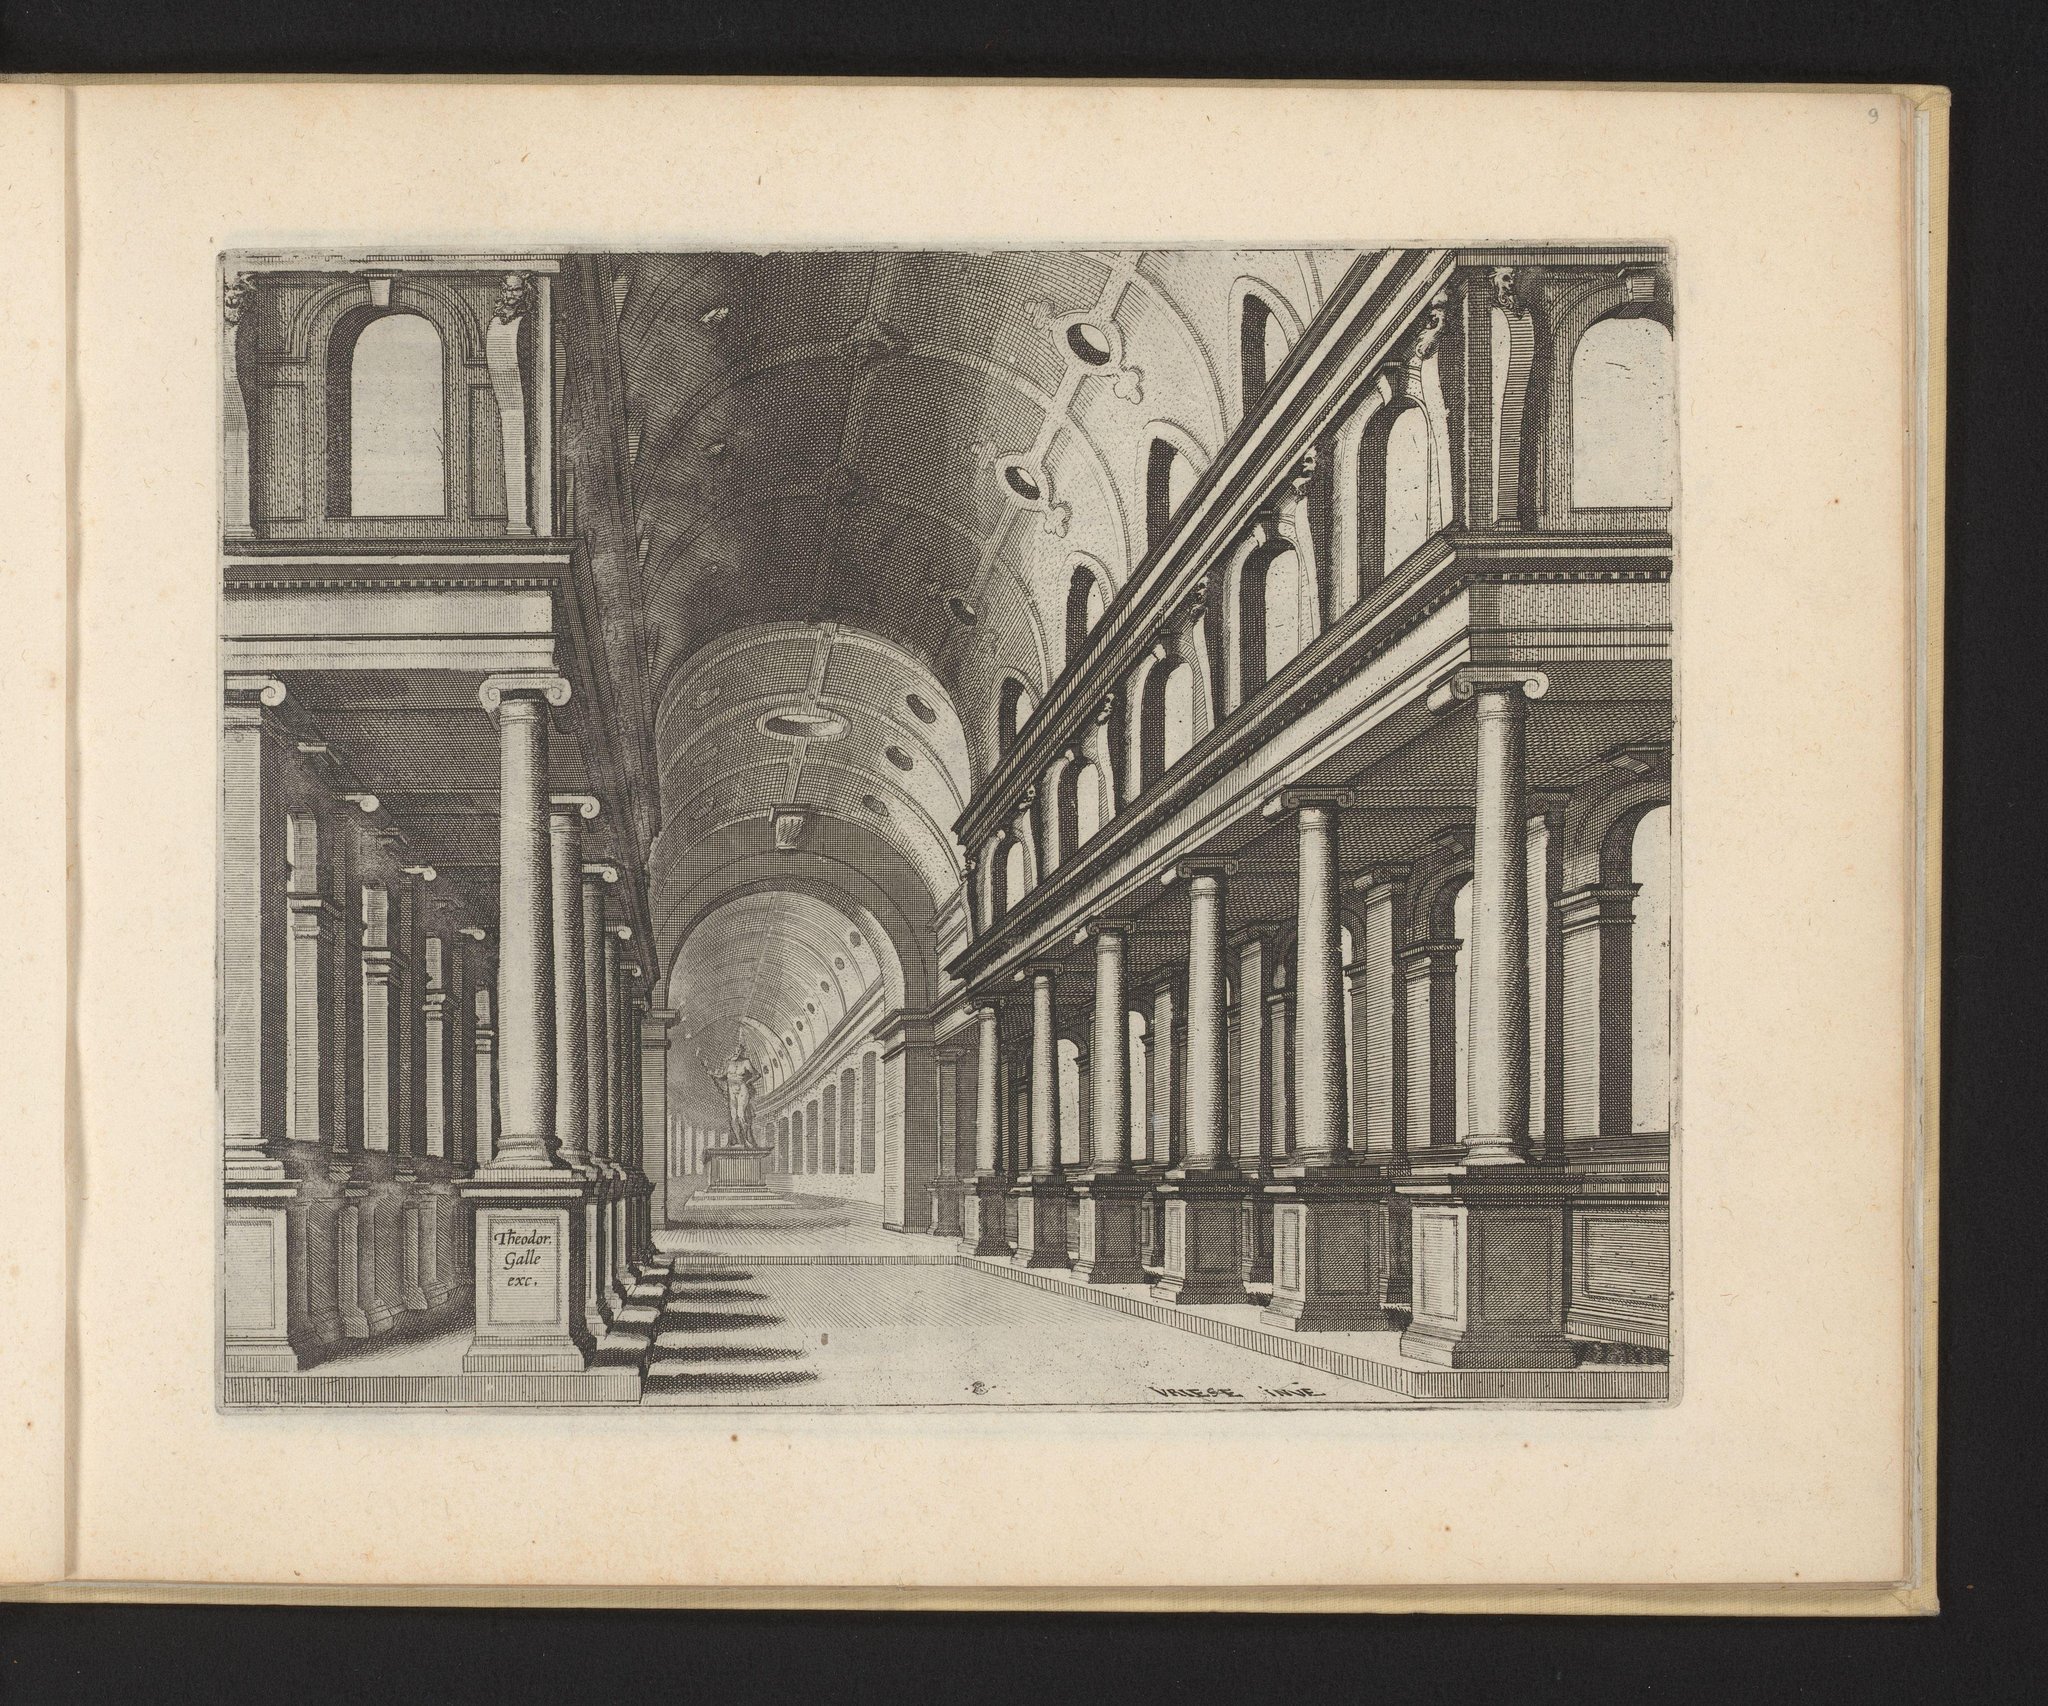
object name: album leaf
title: Interieur van een kerk met een beeld in het koor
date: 1601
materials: paper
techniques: engraving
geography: antwerp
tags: interior of church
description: Interieur van een kerk met zuilen van de Ionische orde en een beeld op een piëdestal in het koor. De prent maakt deel uit van een album.